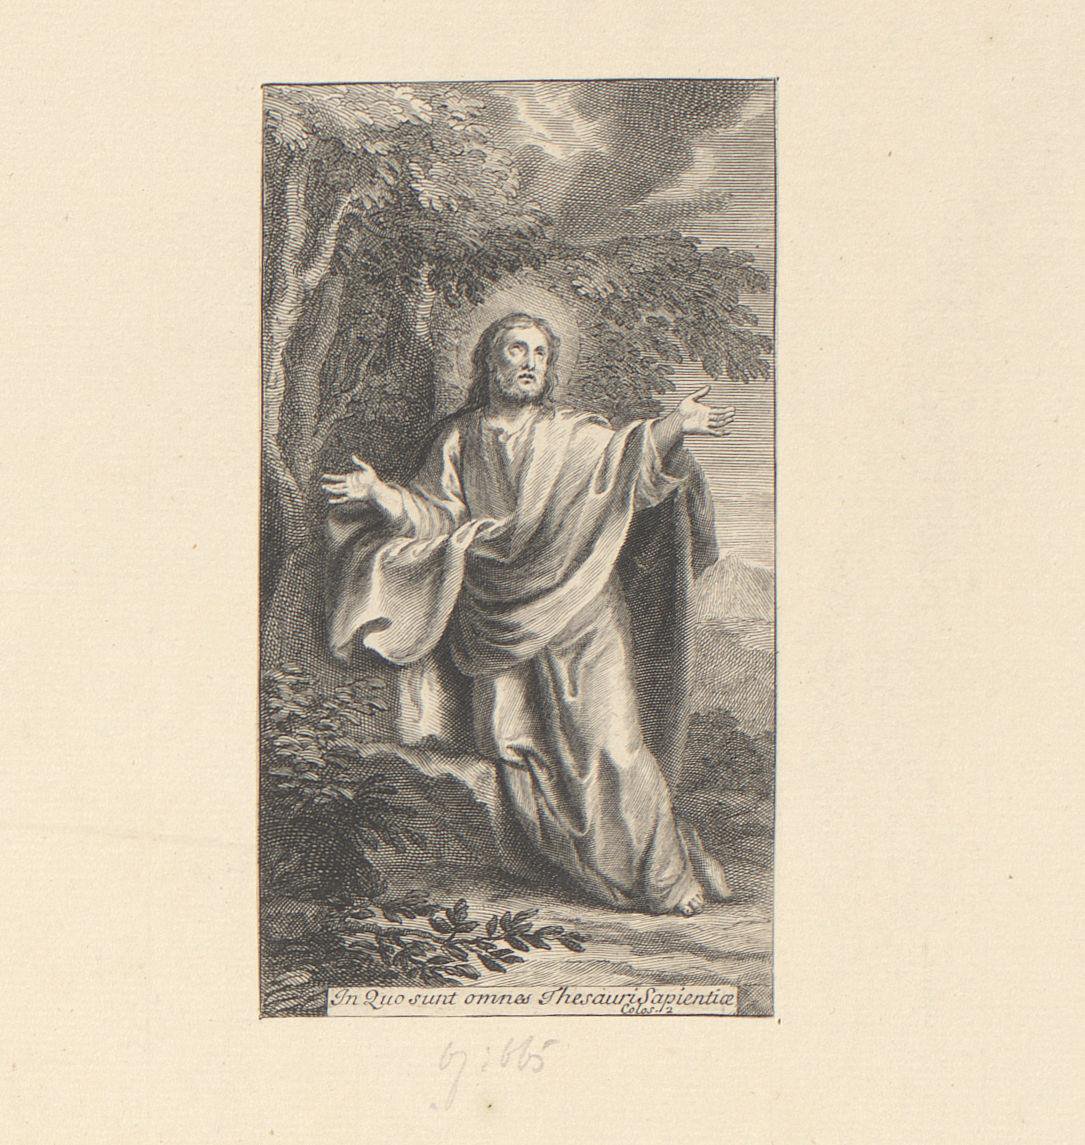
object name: print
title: Werken van Charles le Brun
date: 1650-1700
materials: paper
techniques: engraving, etching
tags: christ on his way to (or in) the garden of gethsemane (not yet praying)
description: Deze prent maakt deel uit van een album.